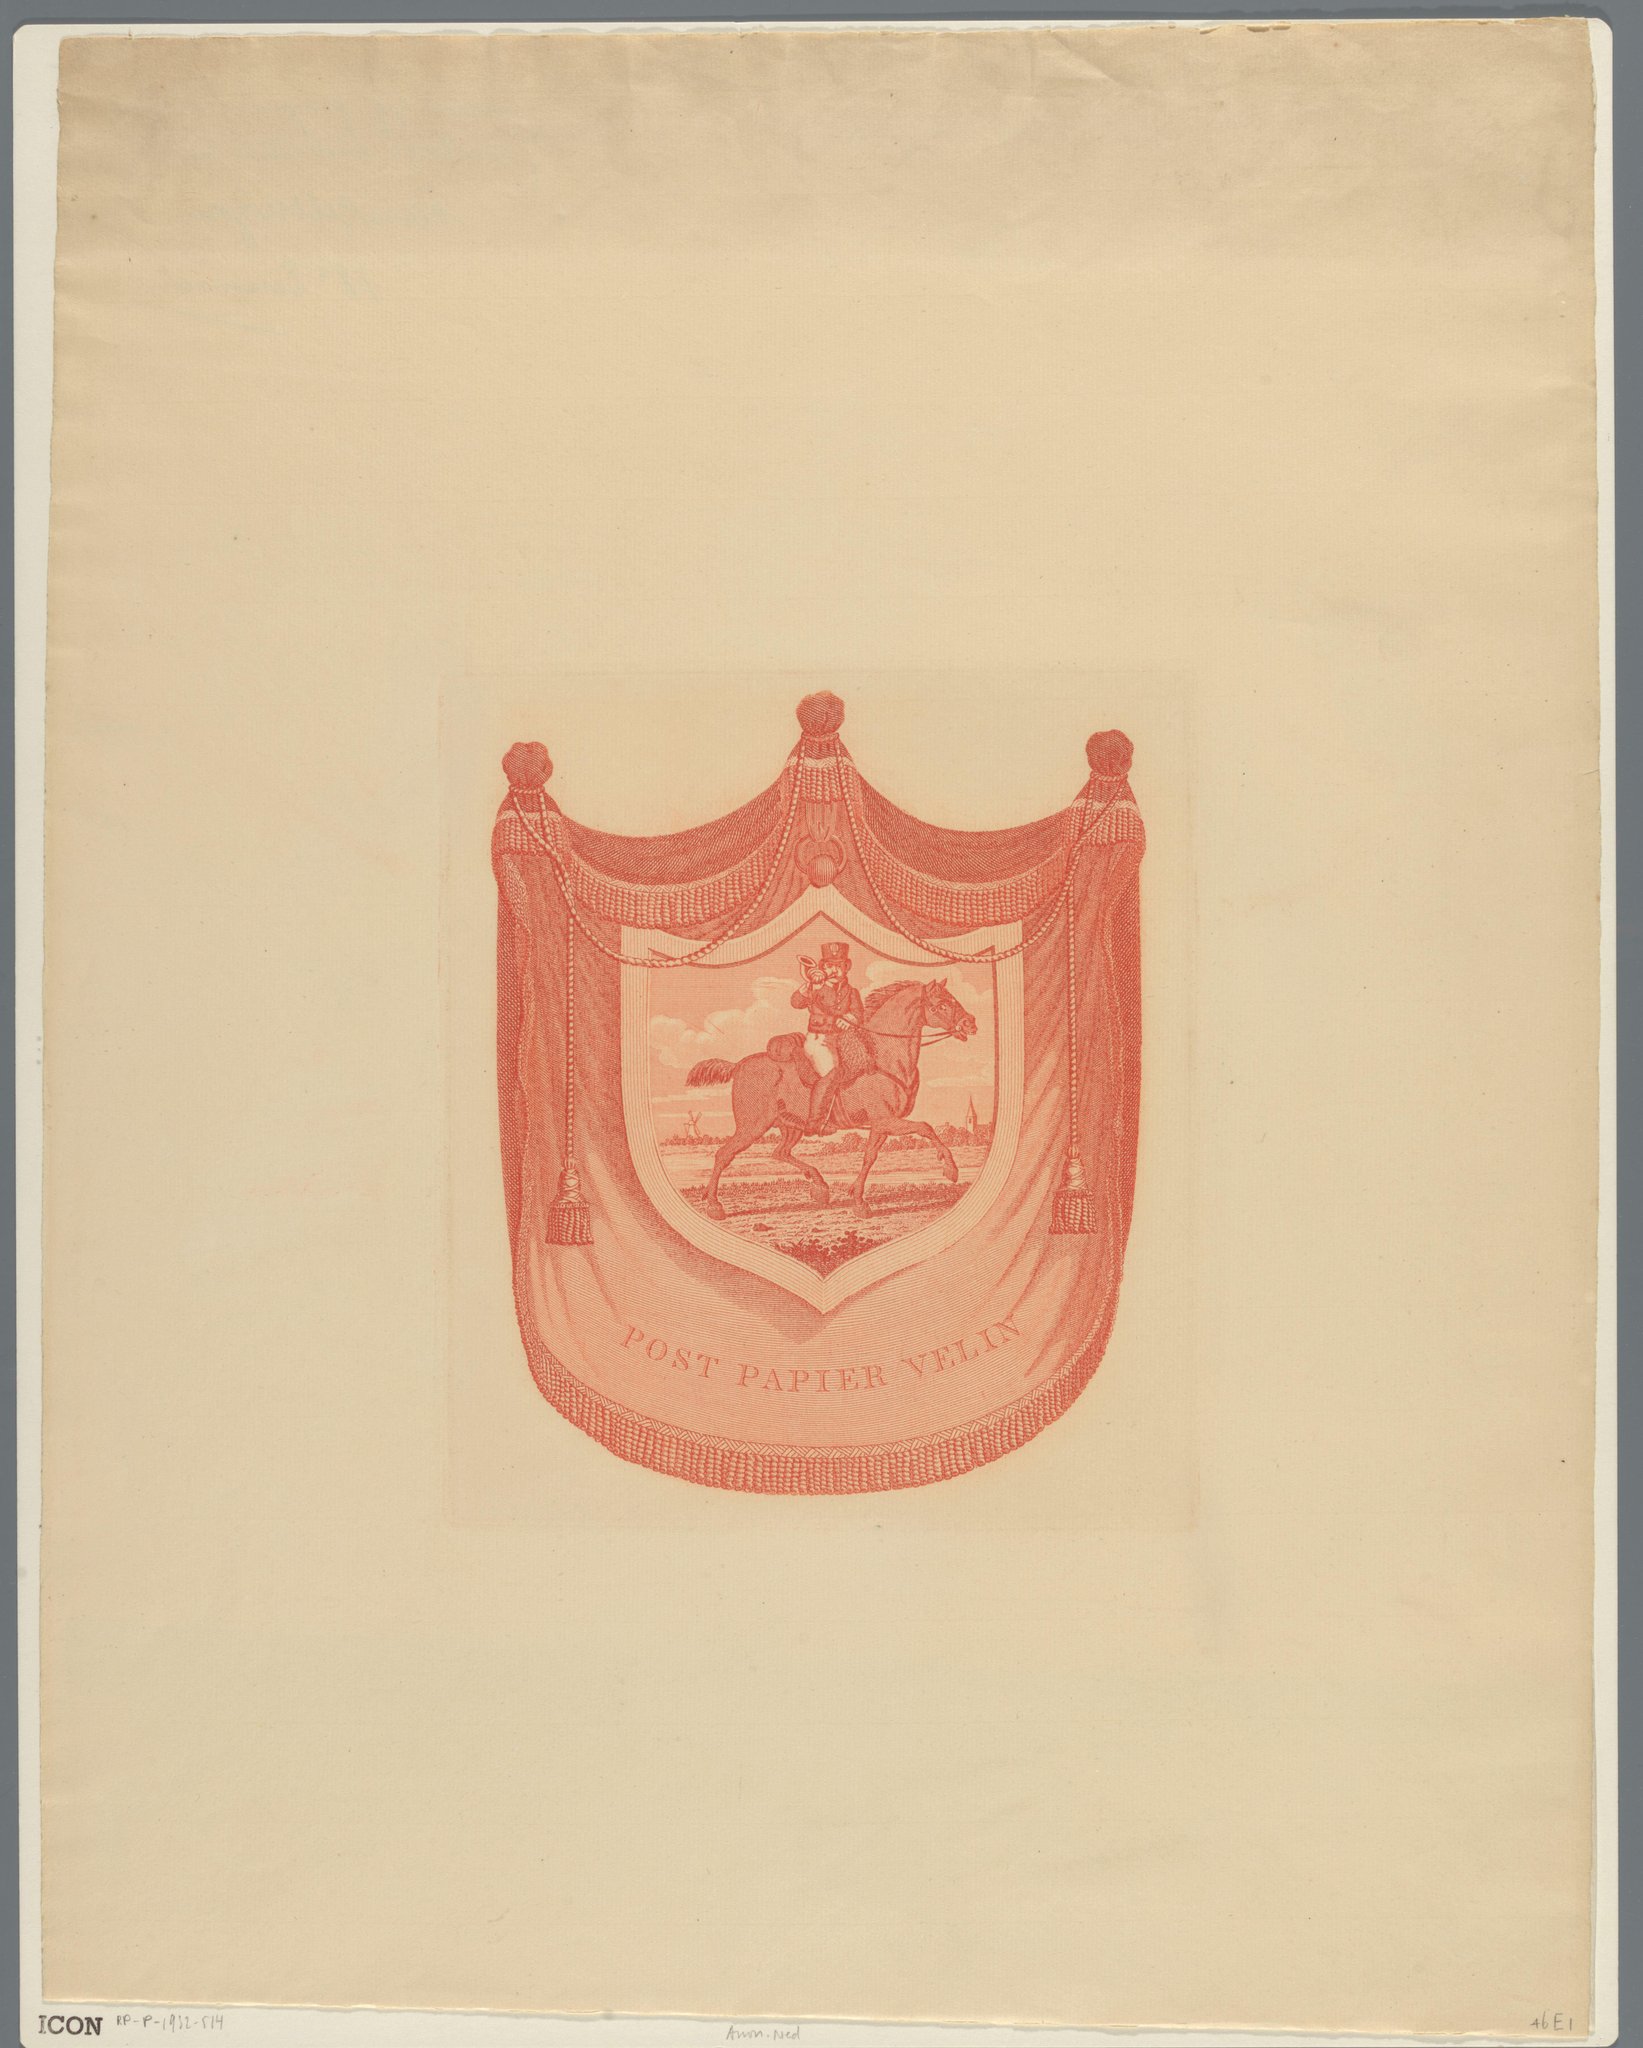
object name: print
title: Riemkap van de firma Van Gelder Papier met postbezorger blazend op een posthoorn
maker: Anonymous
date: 1700-1799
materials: paper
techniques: etching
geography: netherlands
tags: riding a horse, ass, or mule; rider, horseman, container of paper, cardboard: bag, carton, messenger, postman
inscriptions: collector's mark: Lugt 2233, inscription: ‘Oude [...] papierkappen/ (omslagen voor riemen papier)/ van Gelder zonen/ 18e Eeuwsch’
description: Gebaseerd op het watermerk in het papier is dit een twintigste-eeuwse afdruk of reproductie van een achttiende-eeuwse riemkap. Een riemkap was bedoeld als bedekking van een riem papier.